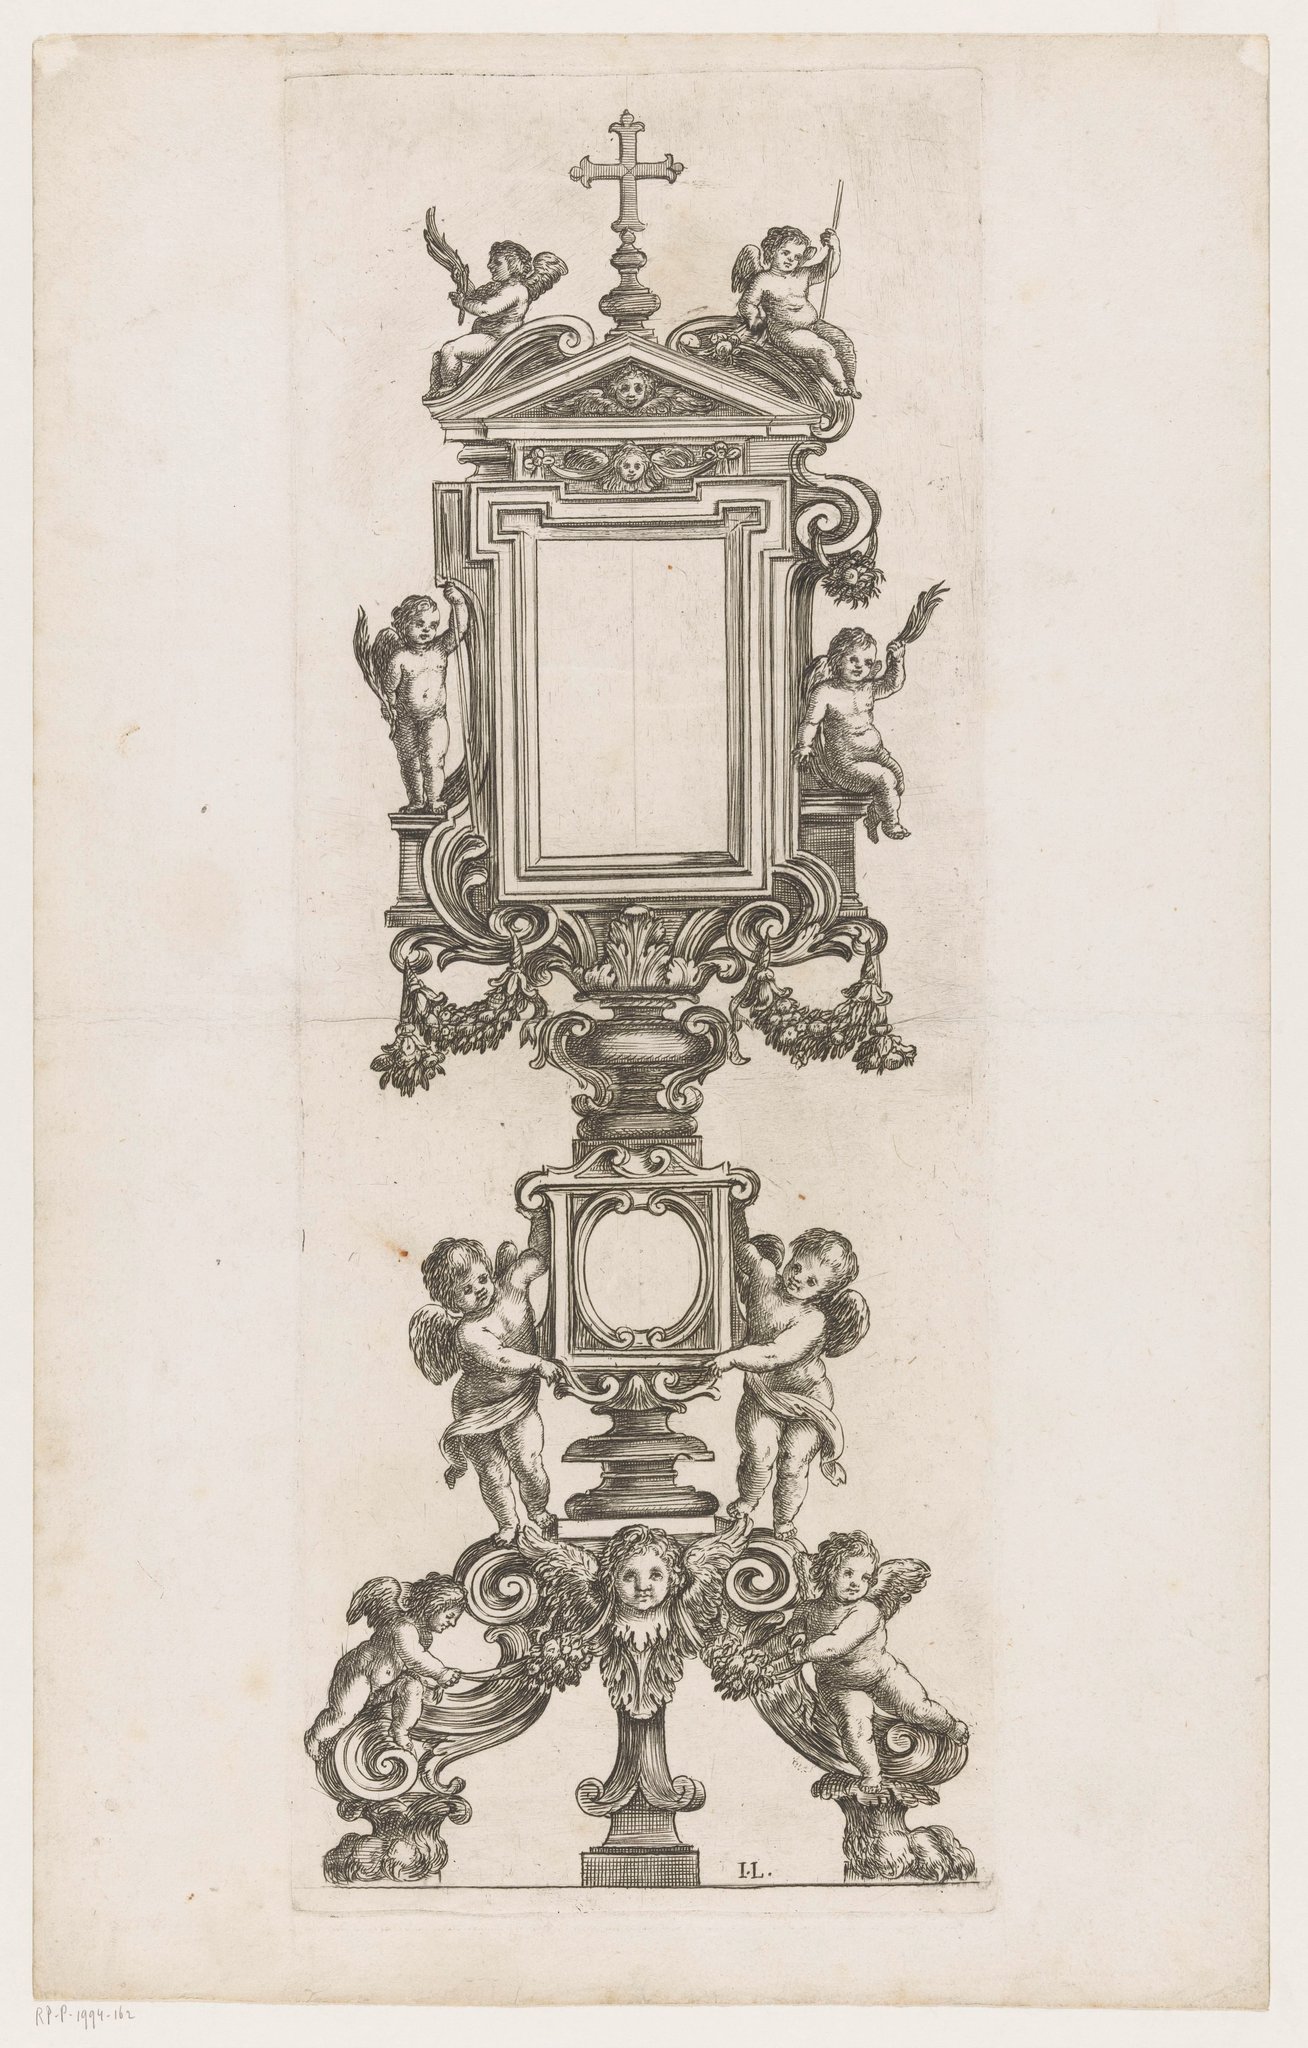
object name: ornament print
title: Monstransen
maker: giacomo laurenziani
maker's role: print maker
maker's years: 1600-1650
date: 1637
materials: paper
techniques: etching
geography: italy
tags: ostensorium, monstrance, cupids: 'amores', 'amoretti', 'putti'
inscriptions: collector's mark: Lugt 2760, collector's mark: Lugt 2228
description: Een monstrans met rechthoekig bovenstuk met fronton. Gedecoreerd met acht putti: twee aan de voet, twee aan de stam, een lege cartouche vasthoudend, aan weerszijden van het bovenste gedeelte en twee op het fronton, dat wordt bekroond met een crucifix.